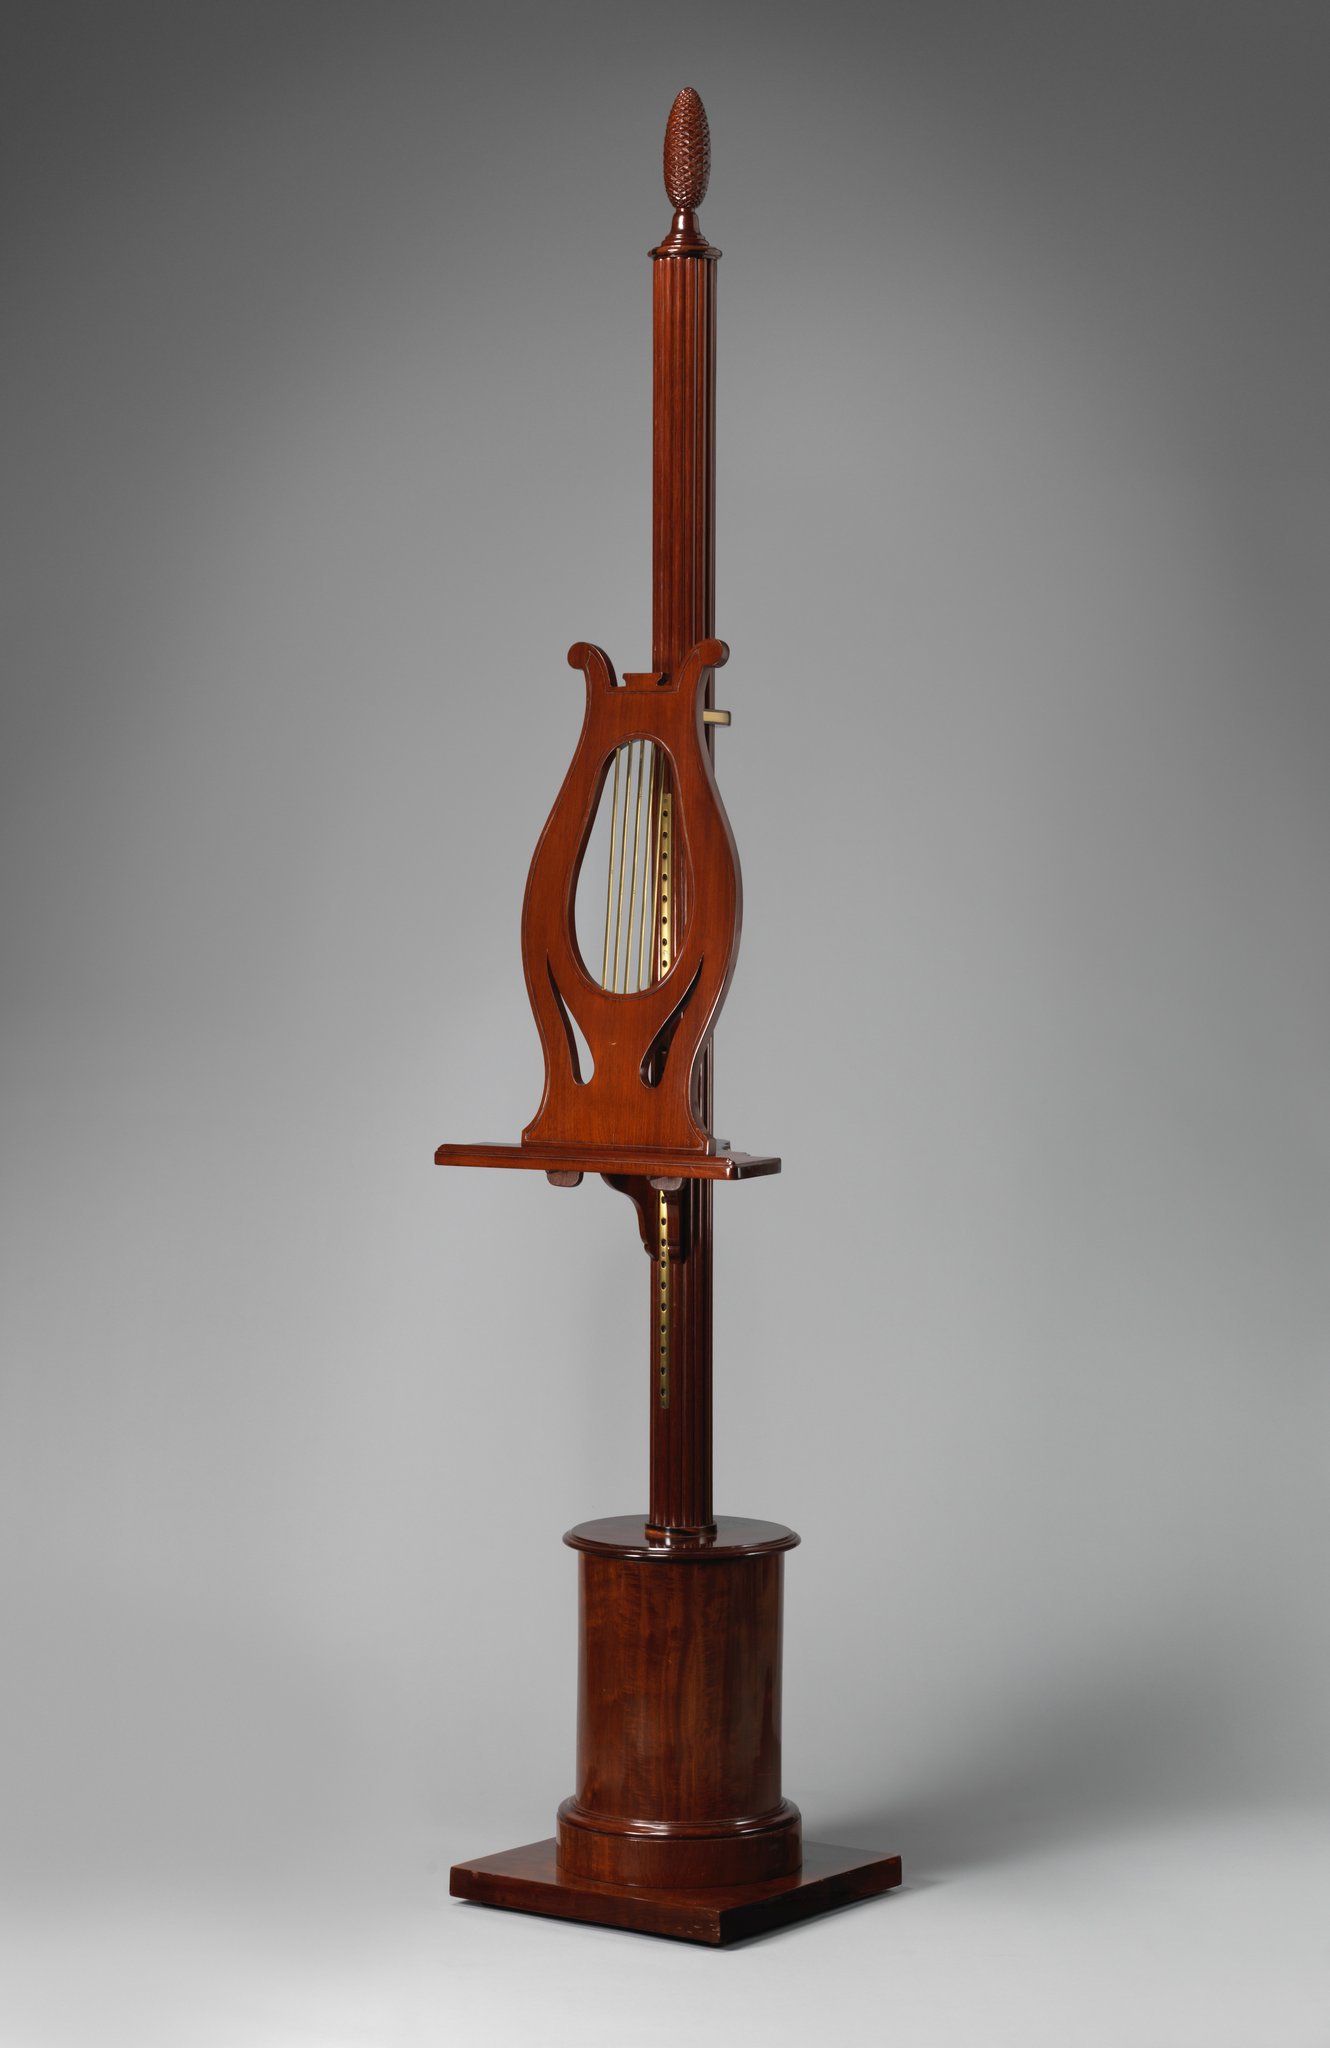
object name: stand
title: Adjustable stand (pupitre de milieu)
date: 1800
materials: brass, wood